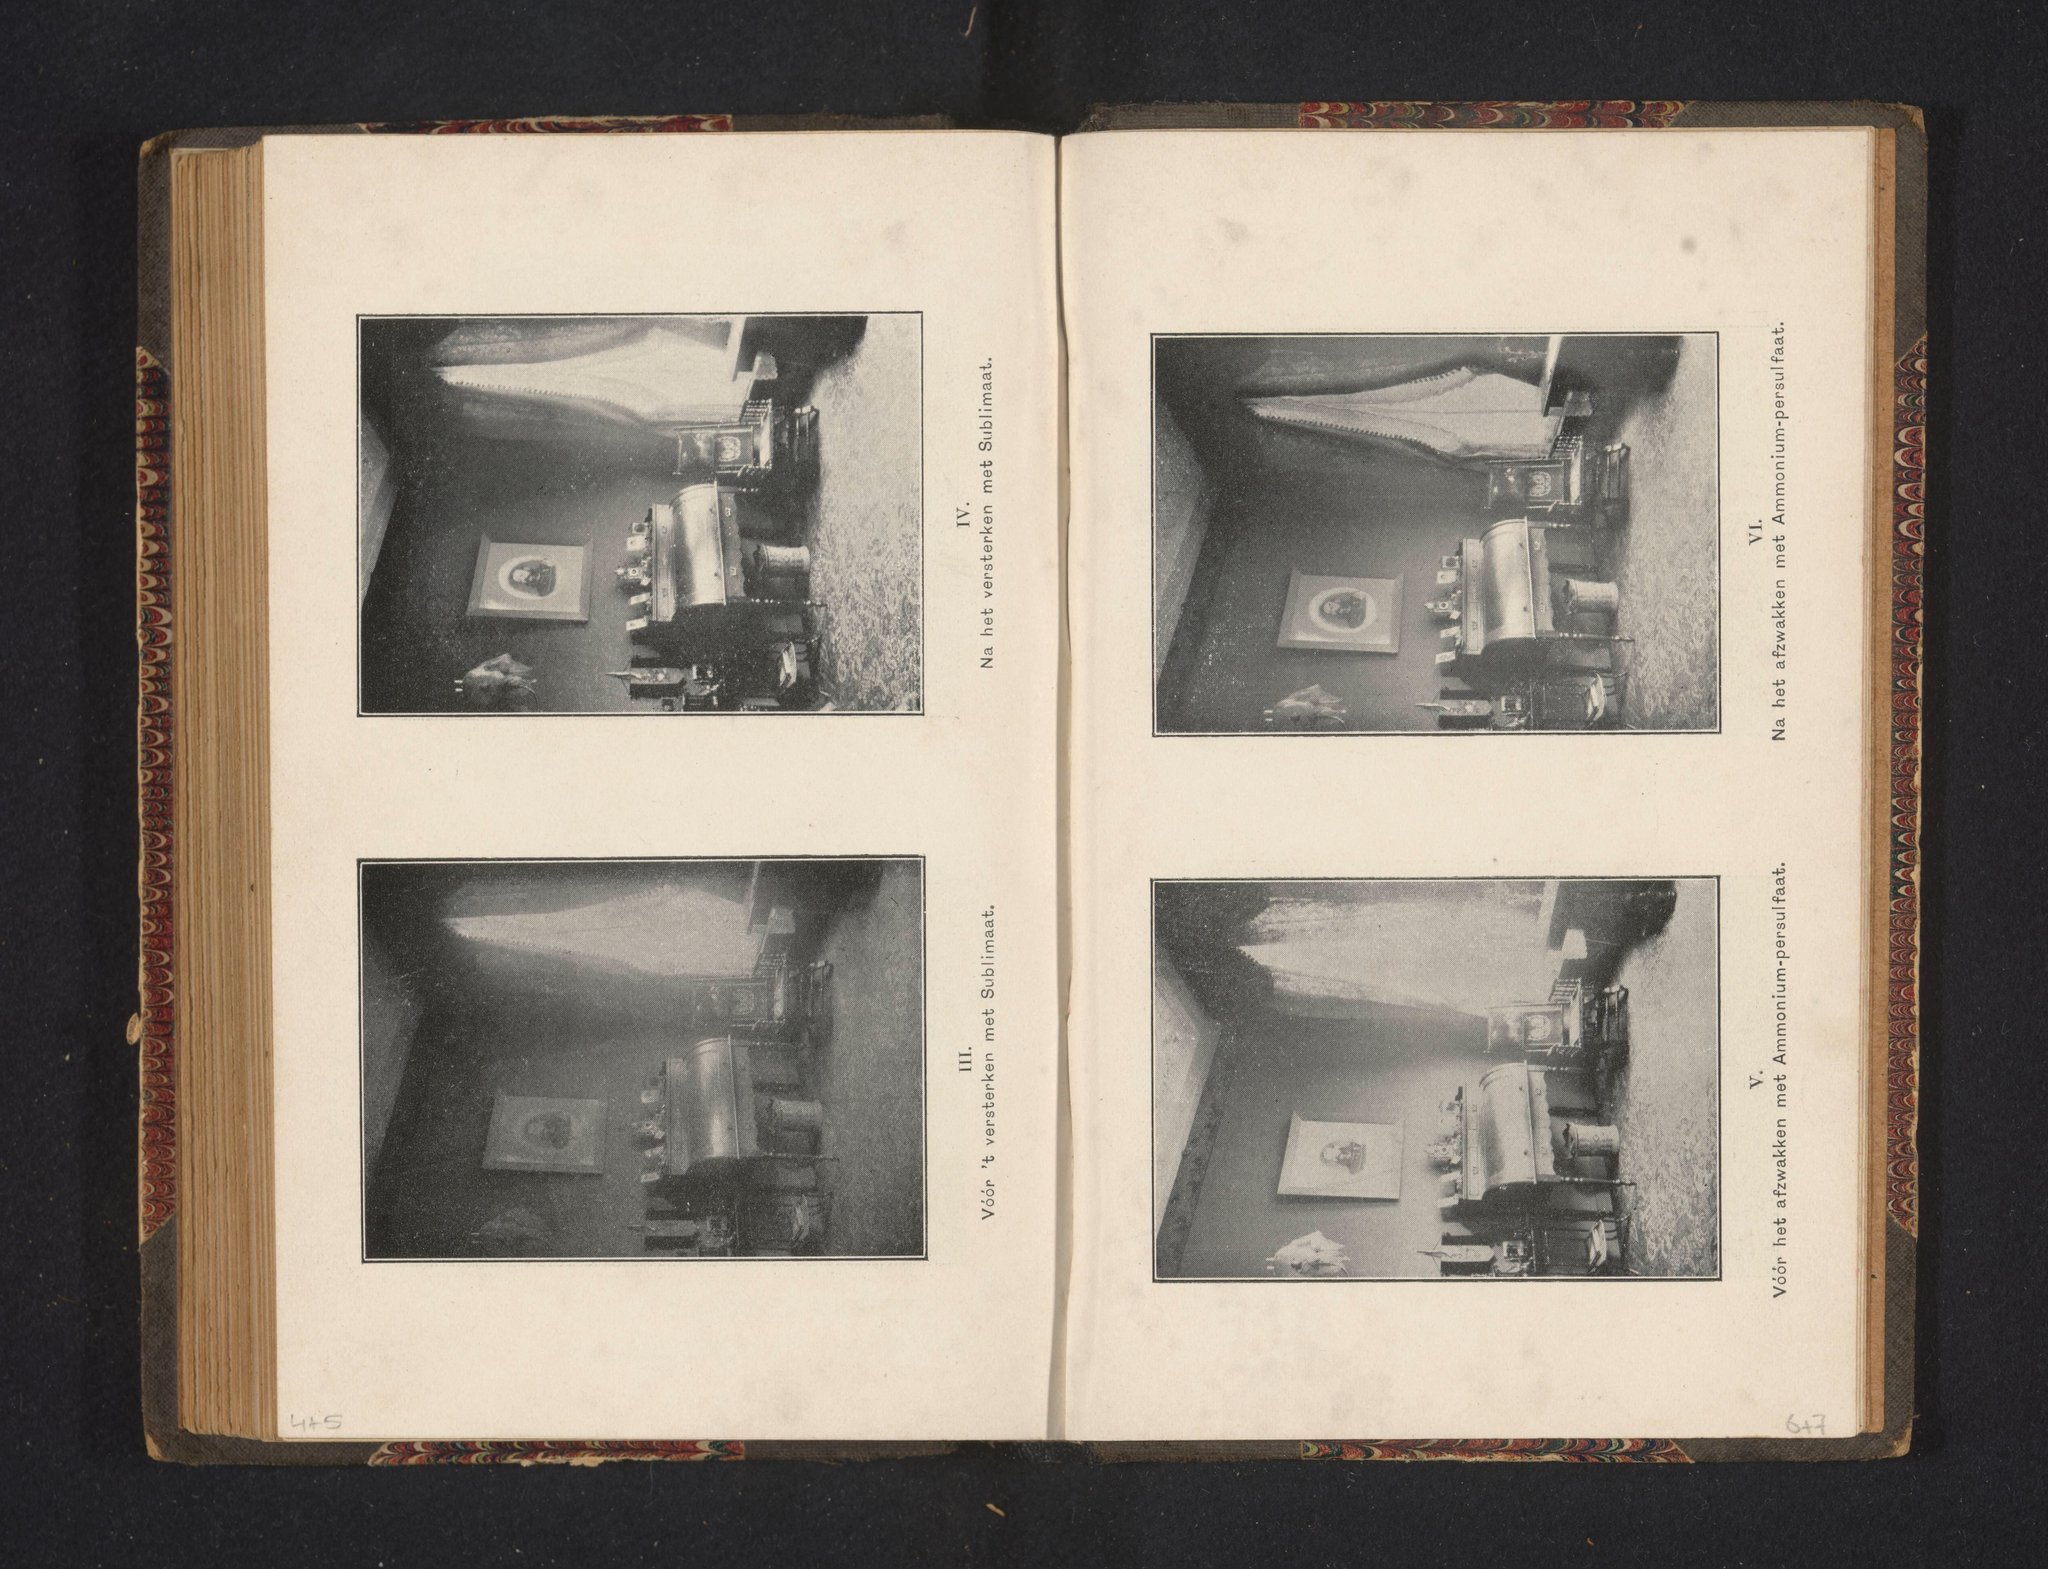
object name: photomechanical print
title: VI./ Na het afzwakken met Ammonium-persulfaat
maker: Anonymous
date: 1897-1902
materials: paper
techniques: autotype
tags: writing-table, writing-desk, interior of the house, chair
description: Prent zes van veertien prenten na pagina 241.